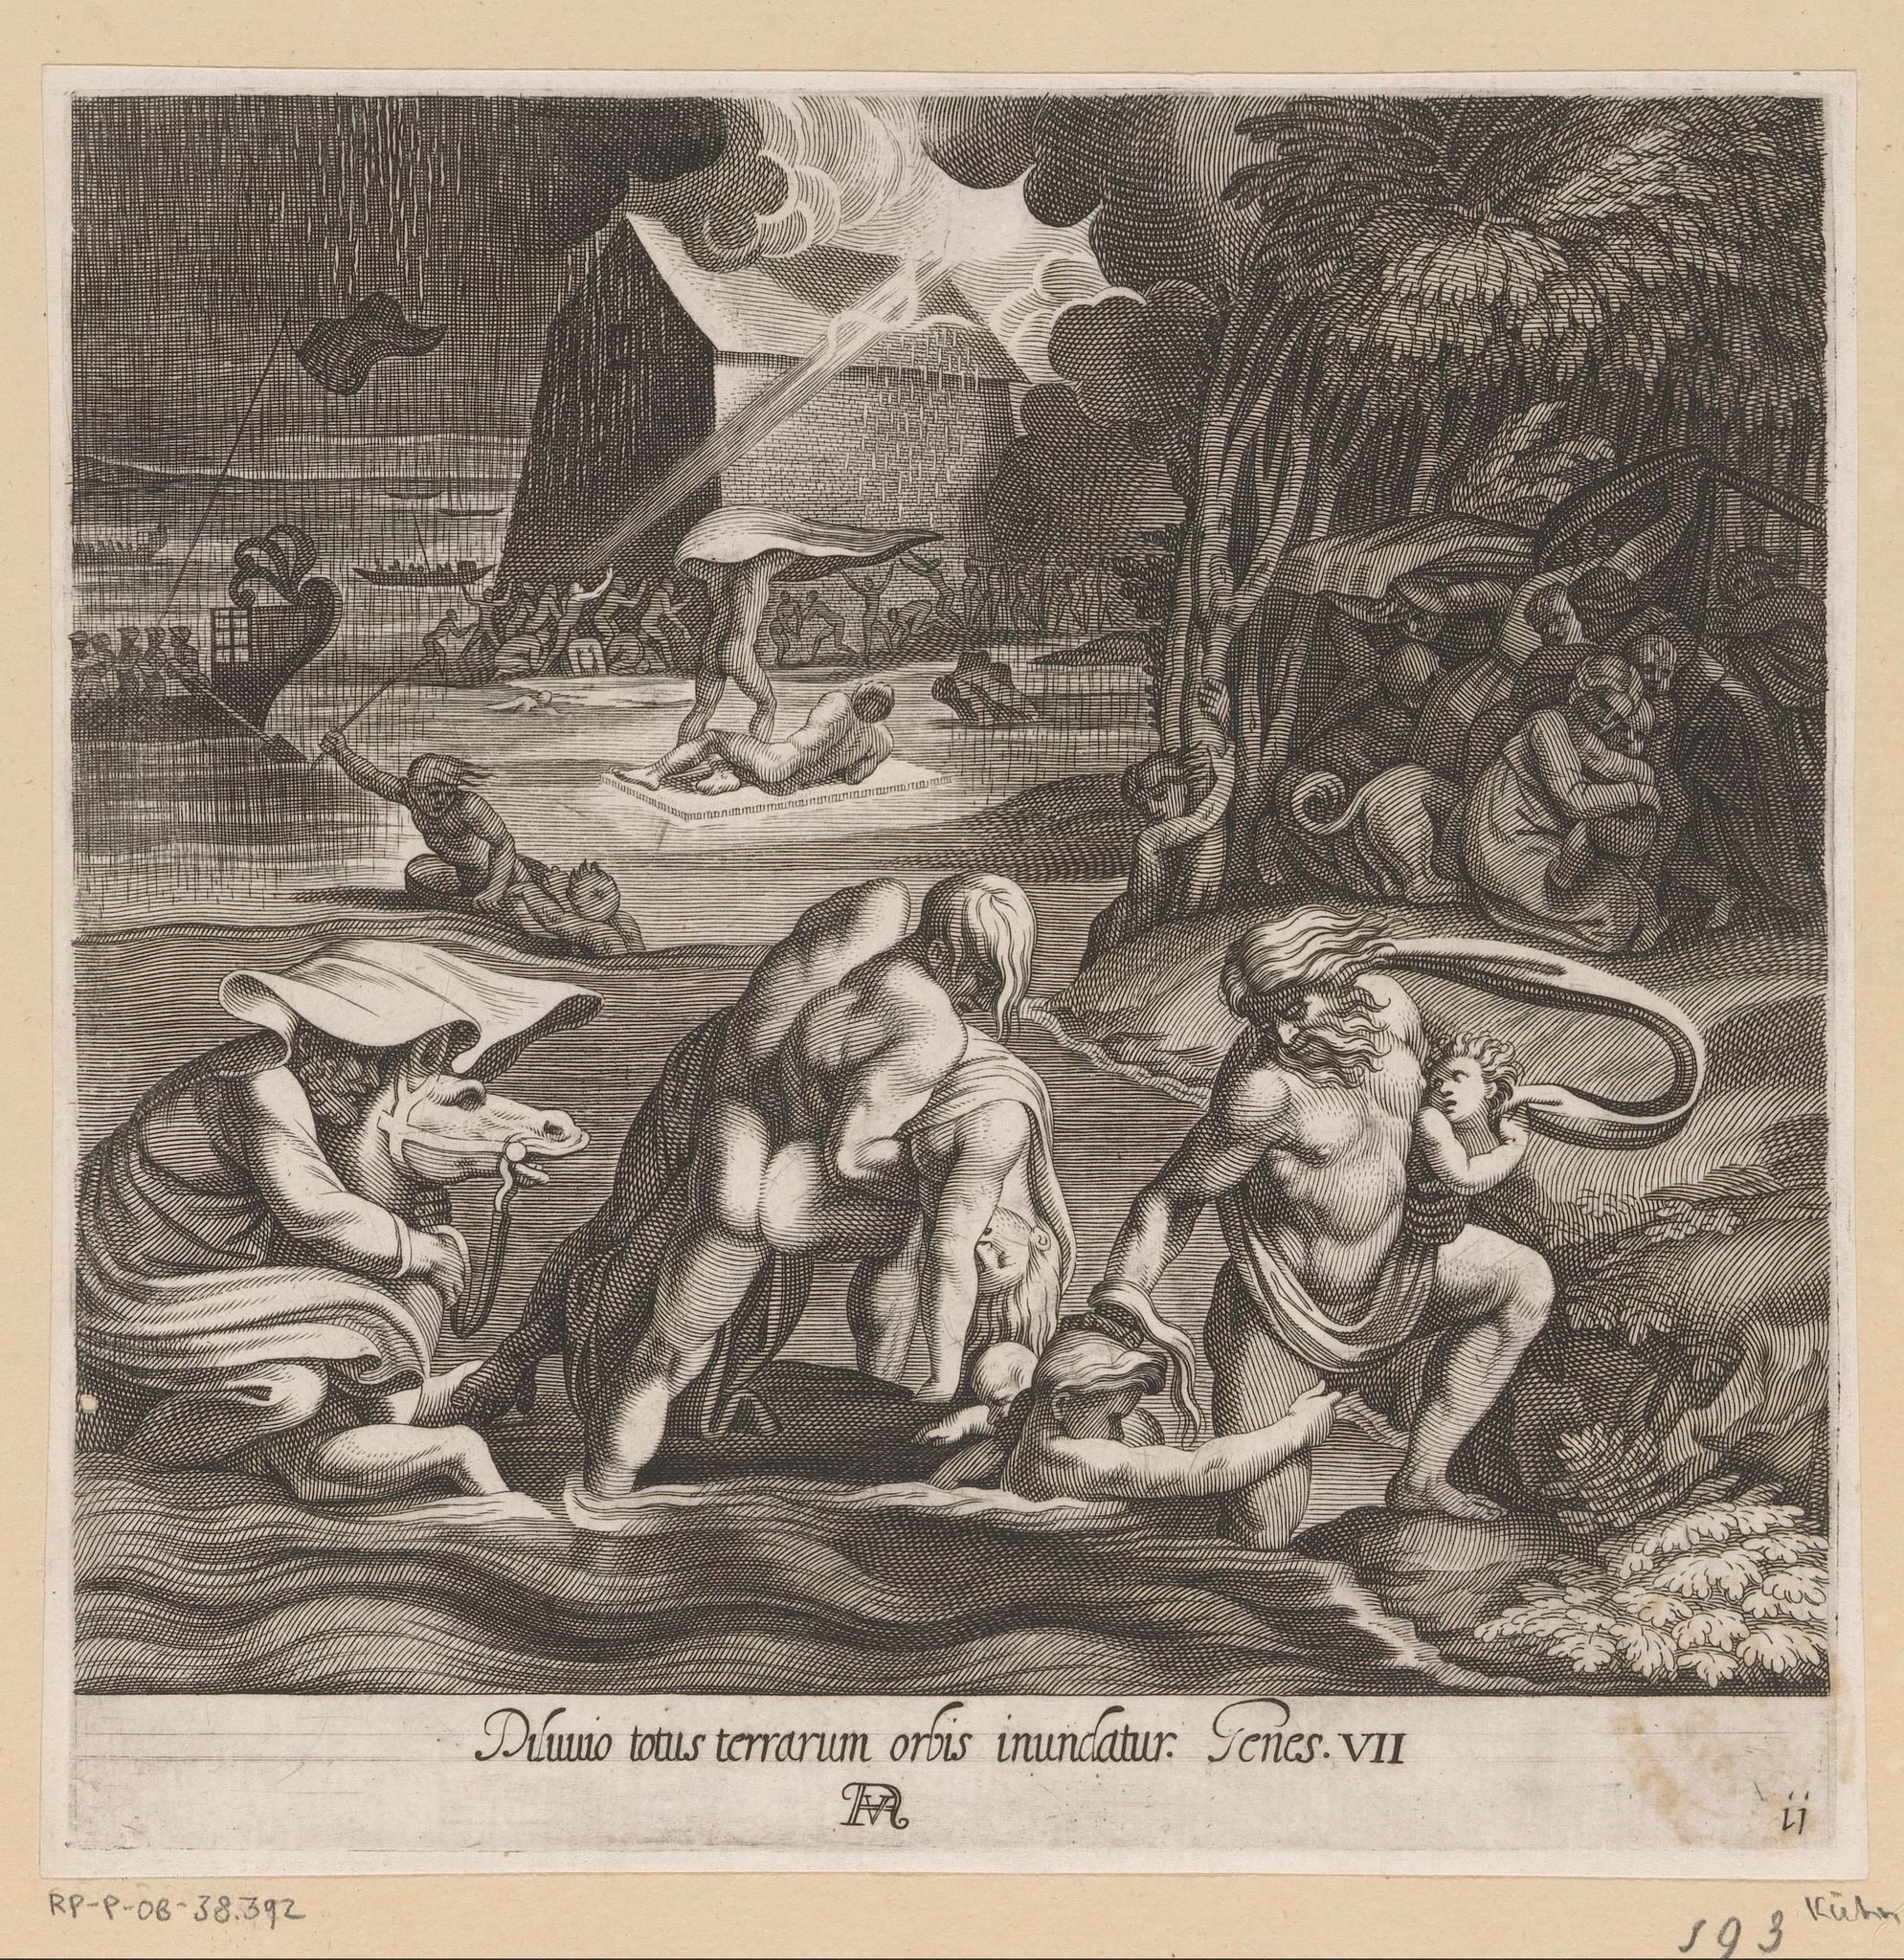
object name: print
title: Zondvloed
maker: francesco villamena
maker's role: draughtsman, painter, print maker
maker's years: 1566-1624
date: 1626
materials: paper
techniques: engraving, etching, intaglio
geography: italy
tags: the flood and destruction of mankind ~ story of noah (genesis 7:10 - 8:17)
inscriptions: collector's mark: Lugt 240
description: Deze prent maakt deel uit van een serie bestaande uit een titelprent en twintig prenten door Francesco Villamena naar schilderingen in de Loggia van Rafaël in het Vaticaan. De serie werd na de dood van Villamena gepubliceerd.